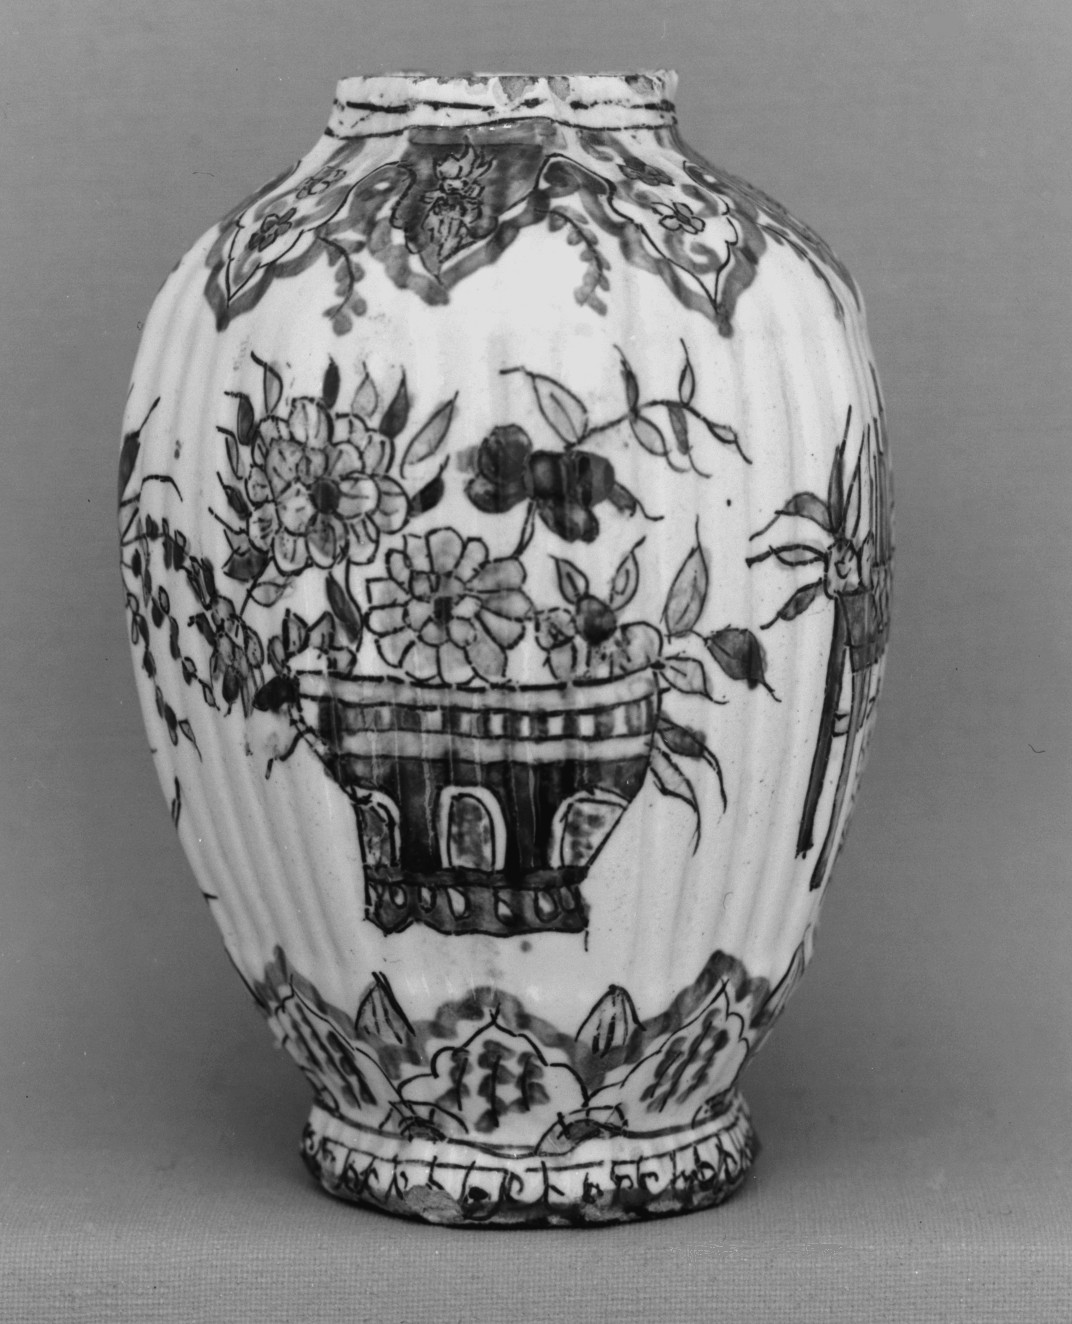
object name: vase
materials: faience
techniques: glazing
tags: flowers